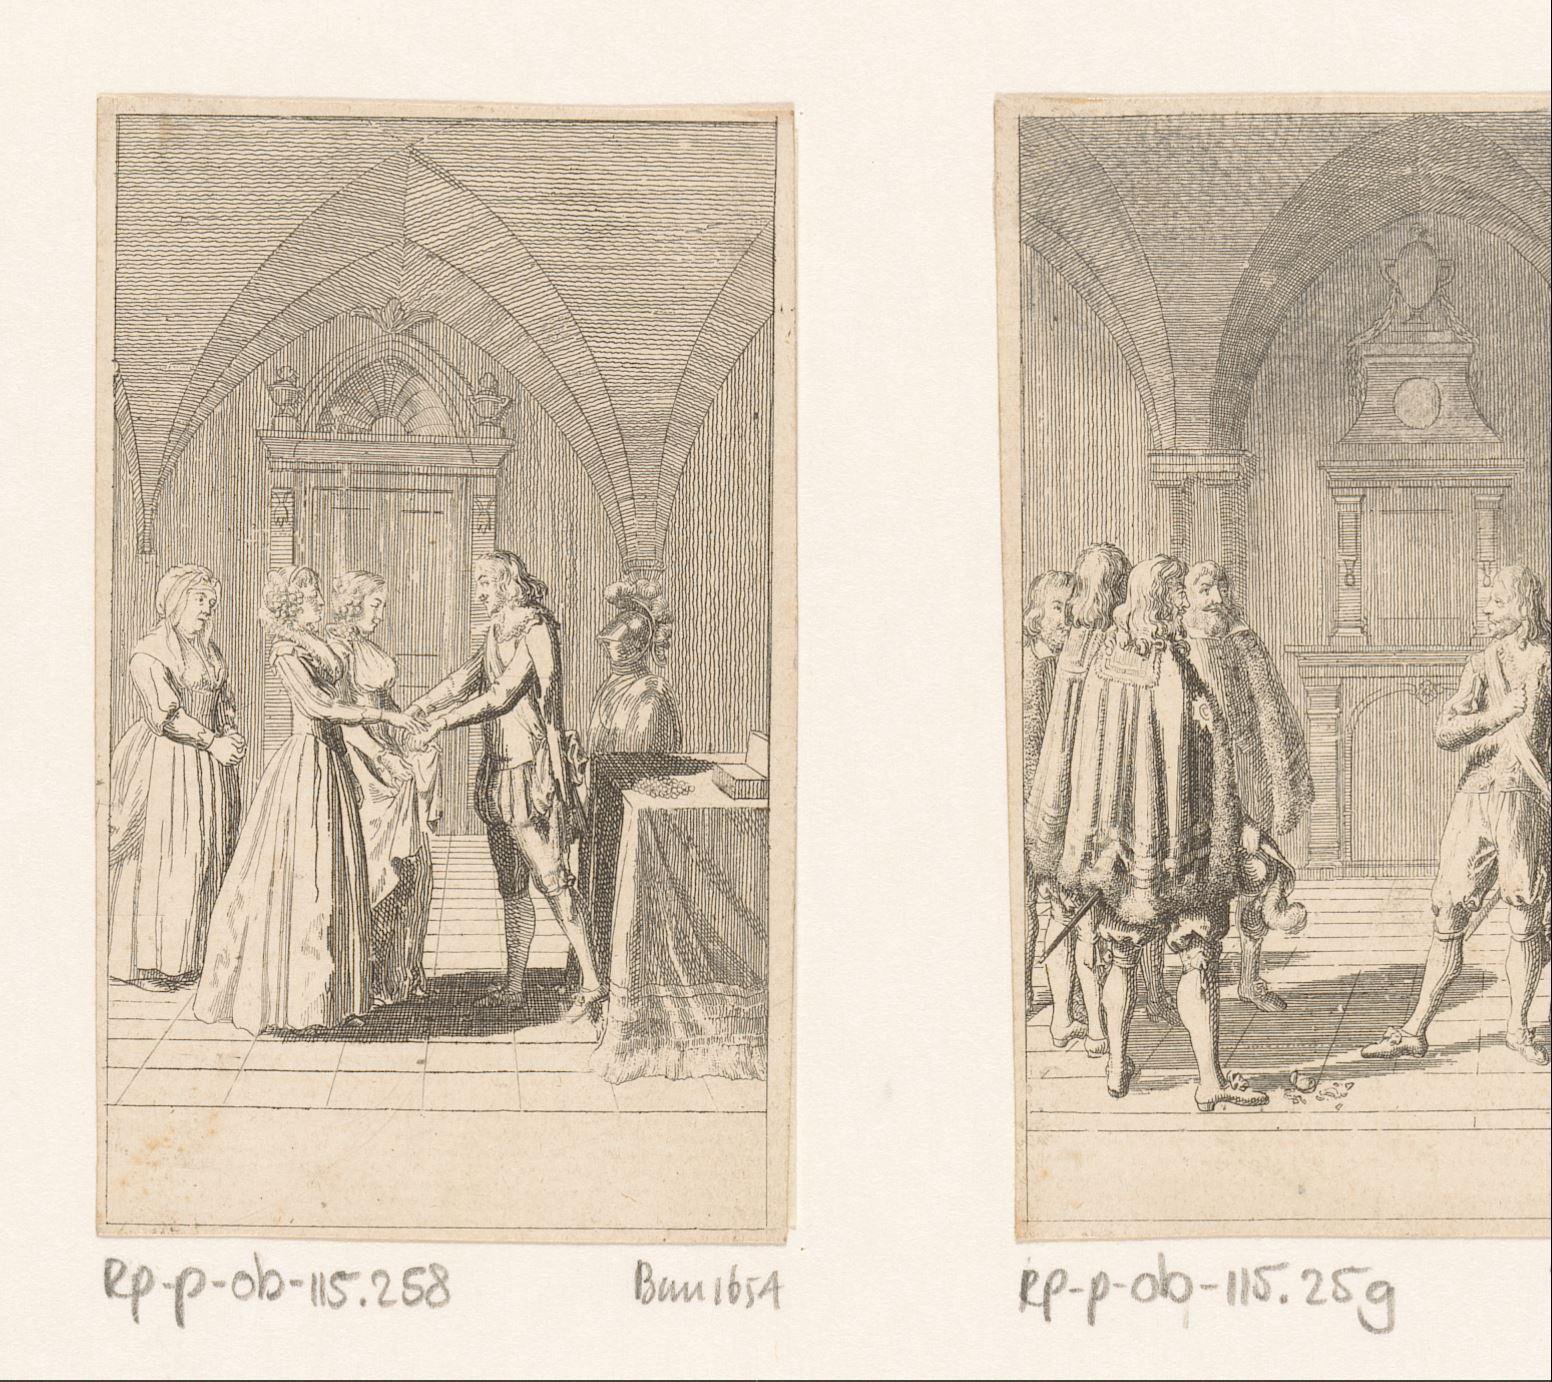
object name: print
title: Pierre Terrail de Bayard met de dochters van de waardin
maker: daniel nikolaus chodowiecki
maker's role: draughtsman, print maker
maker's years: 1726-1801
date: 1793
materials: paper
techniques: etching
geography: berlin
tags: paying (~ commerce) (here also repayment of debt, etc.), history, armour, mother and daughter(s) (family group)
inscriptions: collector's mark: Lugt 2228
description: Vervaardigd als één van twaalf voorstellingen uit de oudste, middelste en nieuwste geschiedenis. Latere staat gebruikt voor: Genealogischen Calender zur angenehmen und nützlichen Unterhaltung auf das Jahr 1794. Berlijn: Königl. Akademie der Wissenschaften, [1793].